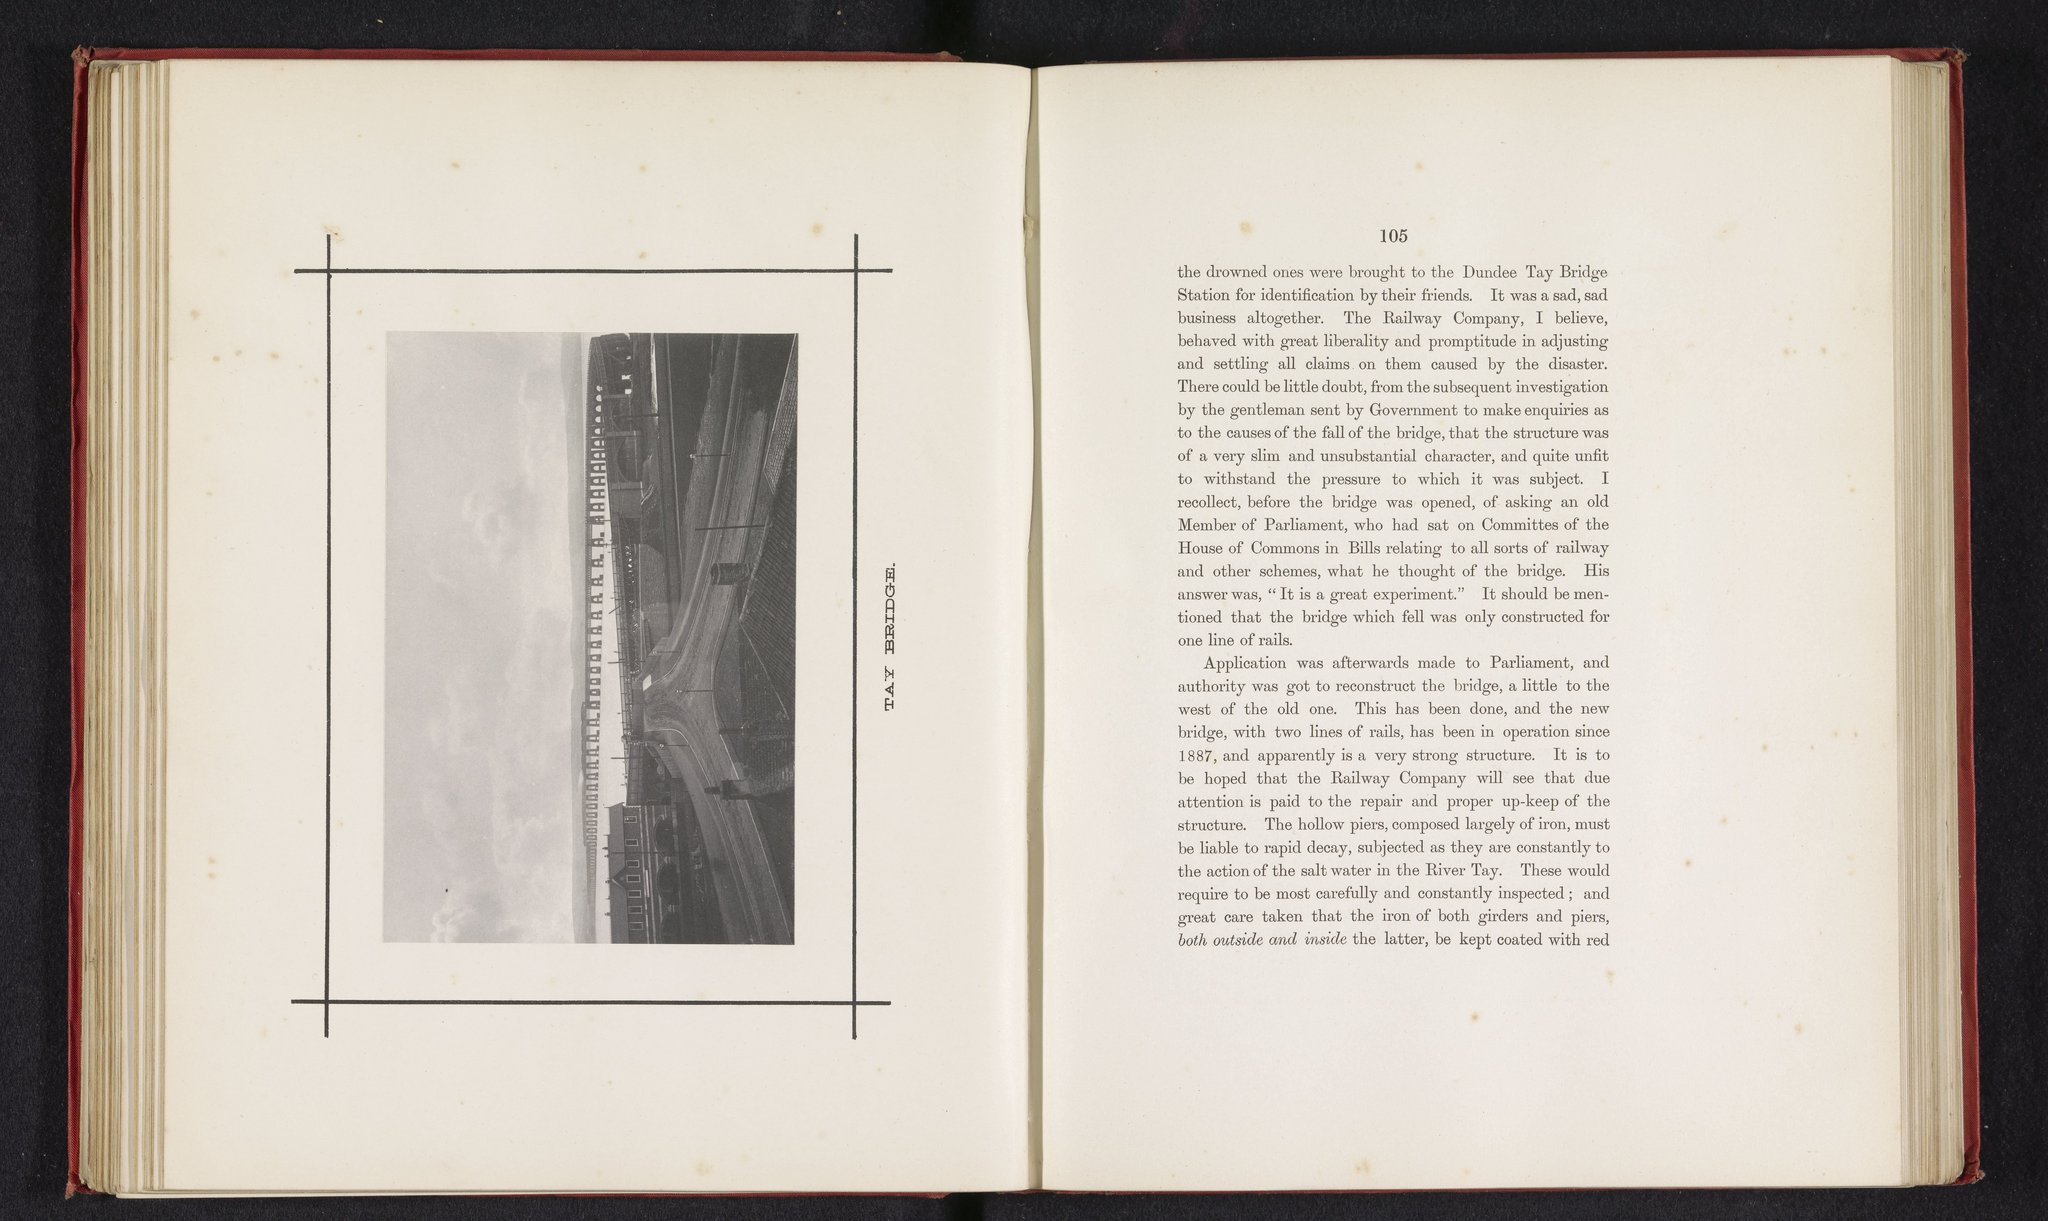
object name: page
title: Gezicht op de nieuwe Tay Bridge bij Dundee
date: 1887-1890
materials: photographic support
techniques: platinum process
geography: dundee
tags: landscape with bridge, viaduct or aqueduct, railway, train